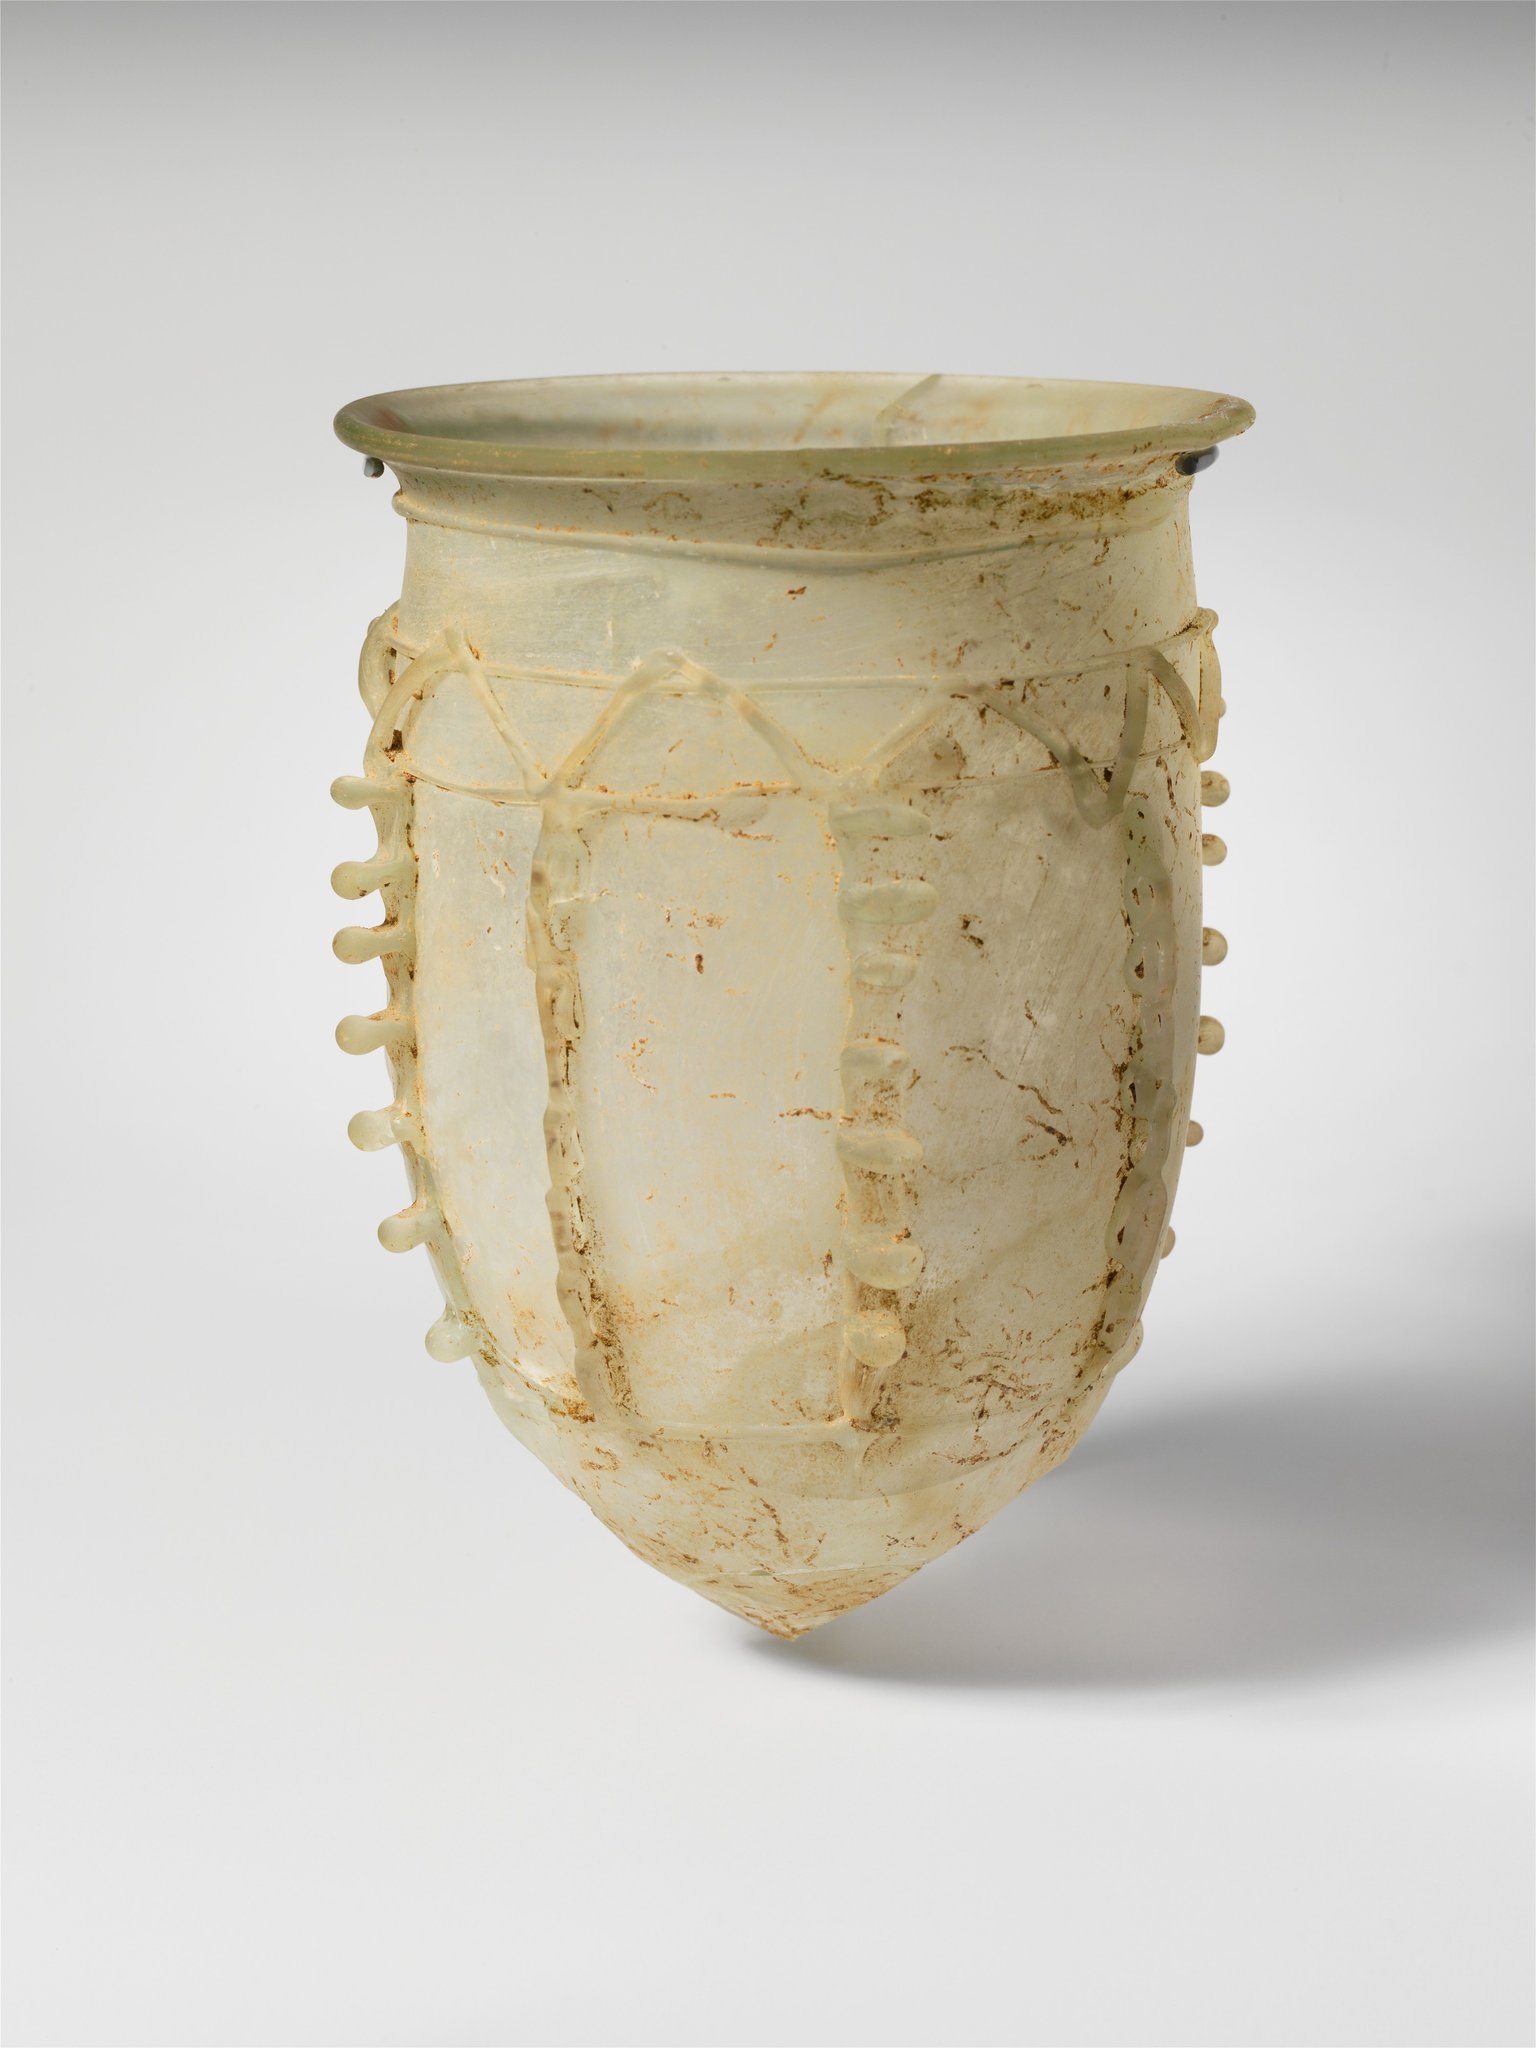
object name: beaker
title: Glass beaker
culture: roman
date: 301-400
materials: glass